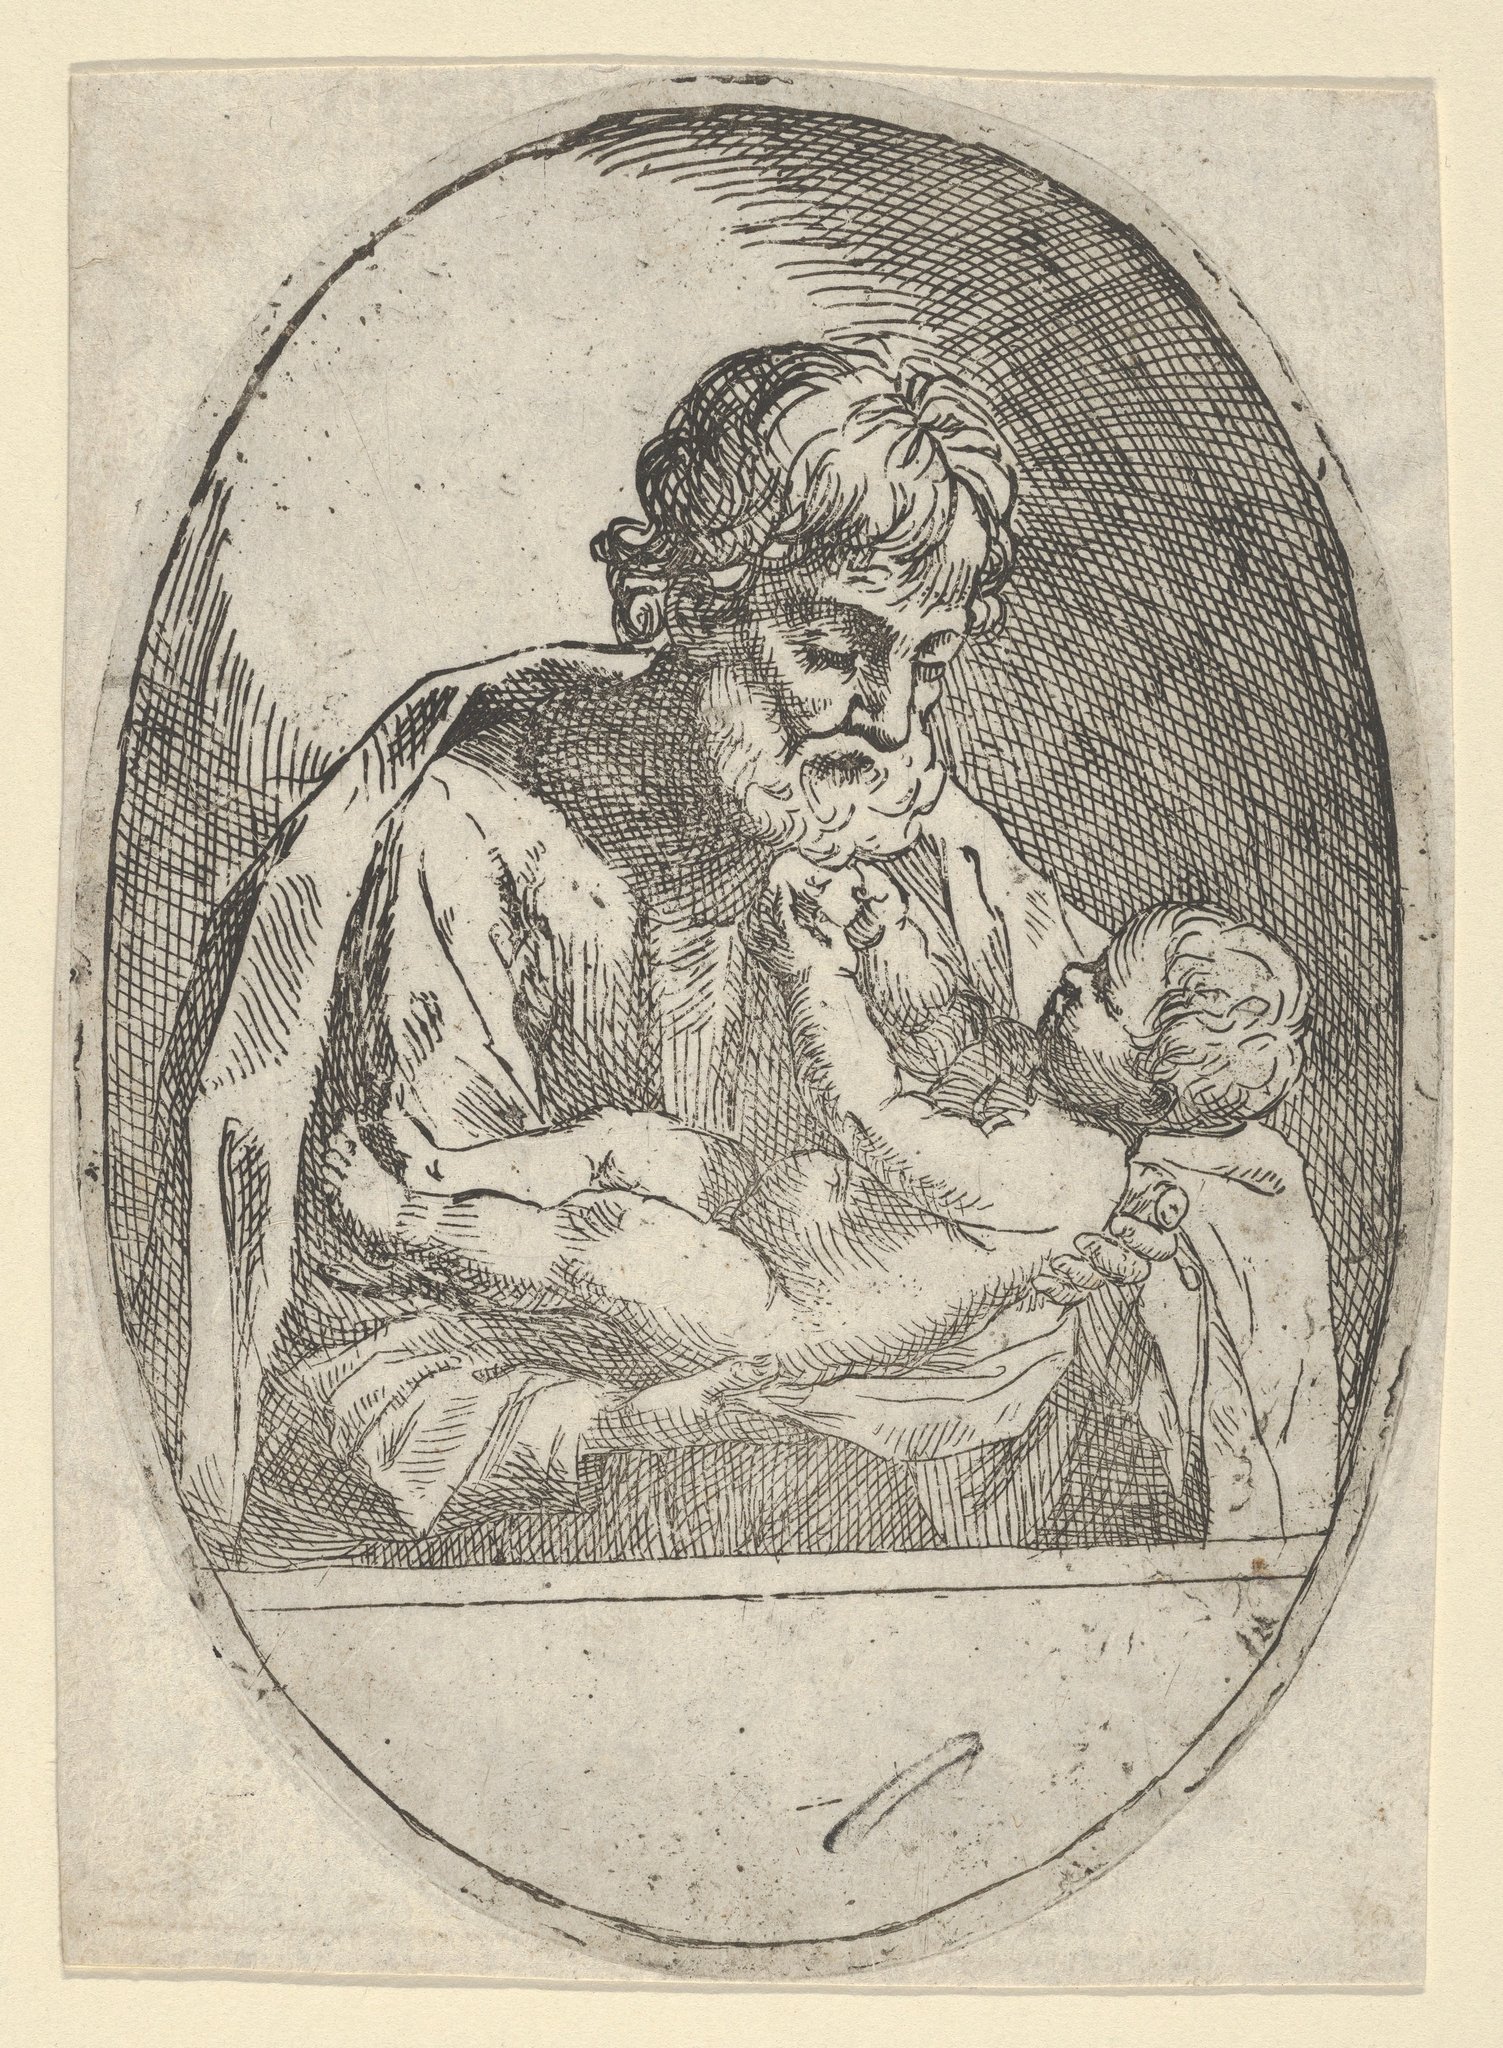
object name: print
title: Saint Joseph holding the infant Christ, who raises up his hands, an oval composition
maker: anonymous, 17th century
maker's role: artist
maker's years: 1600-1700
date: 1600-1660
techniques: etching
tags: christ,saint joseph